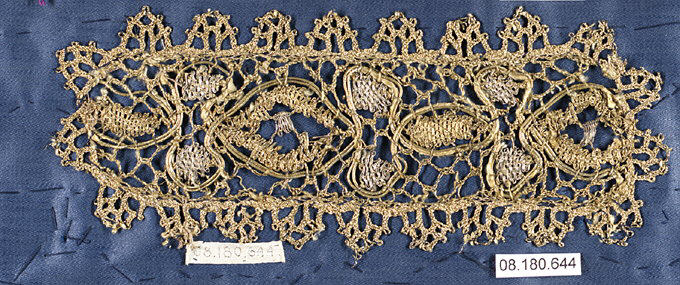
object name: fragment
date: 1601-1700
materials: metal thread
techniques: lace